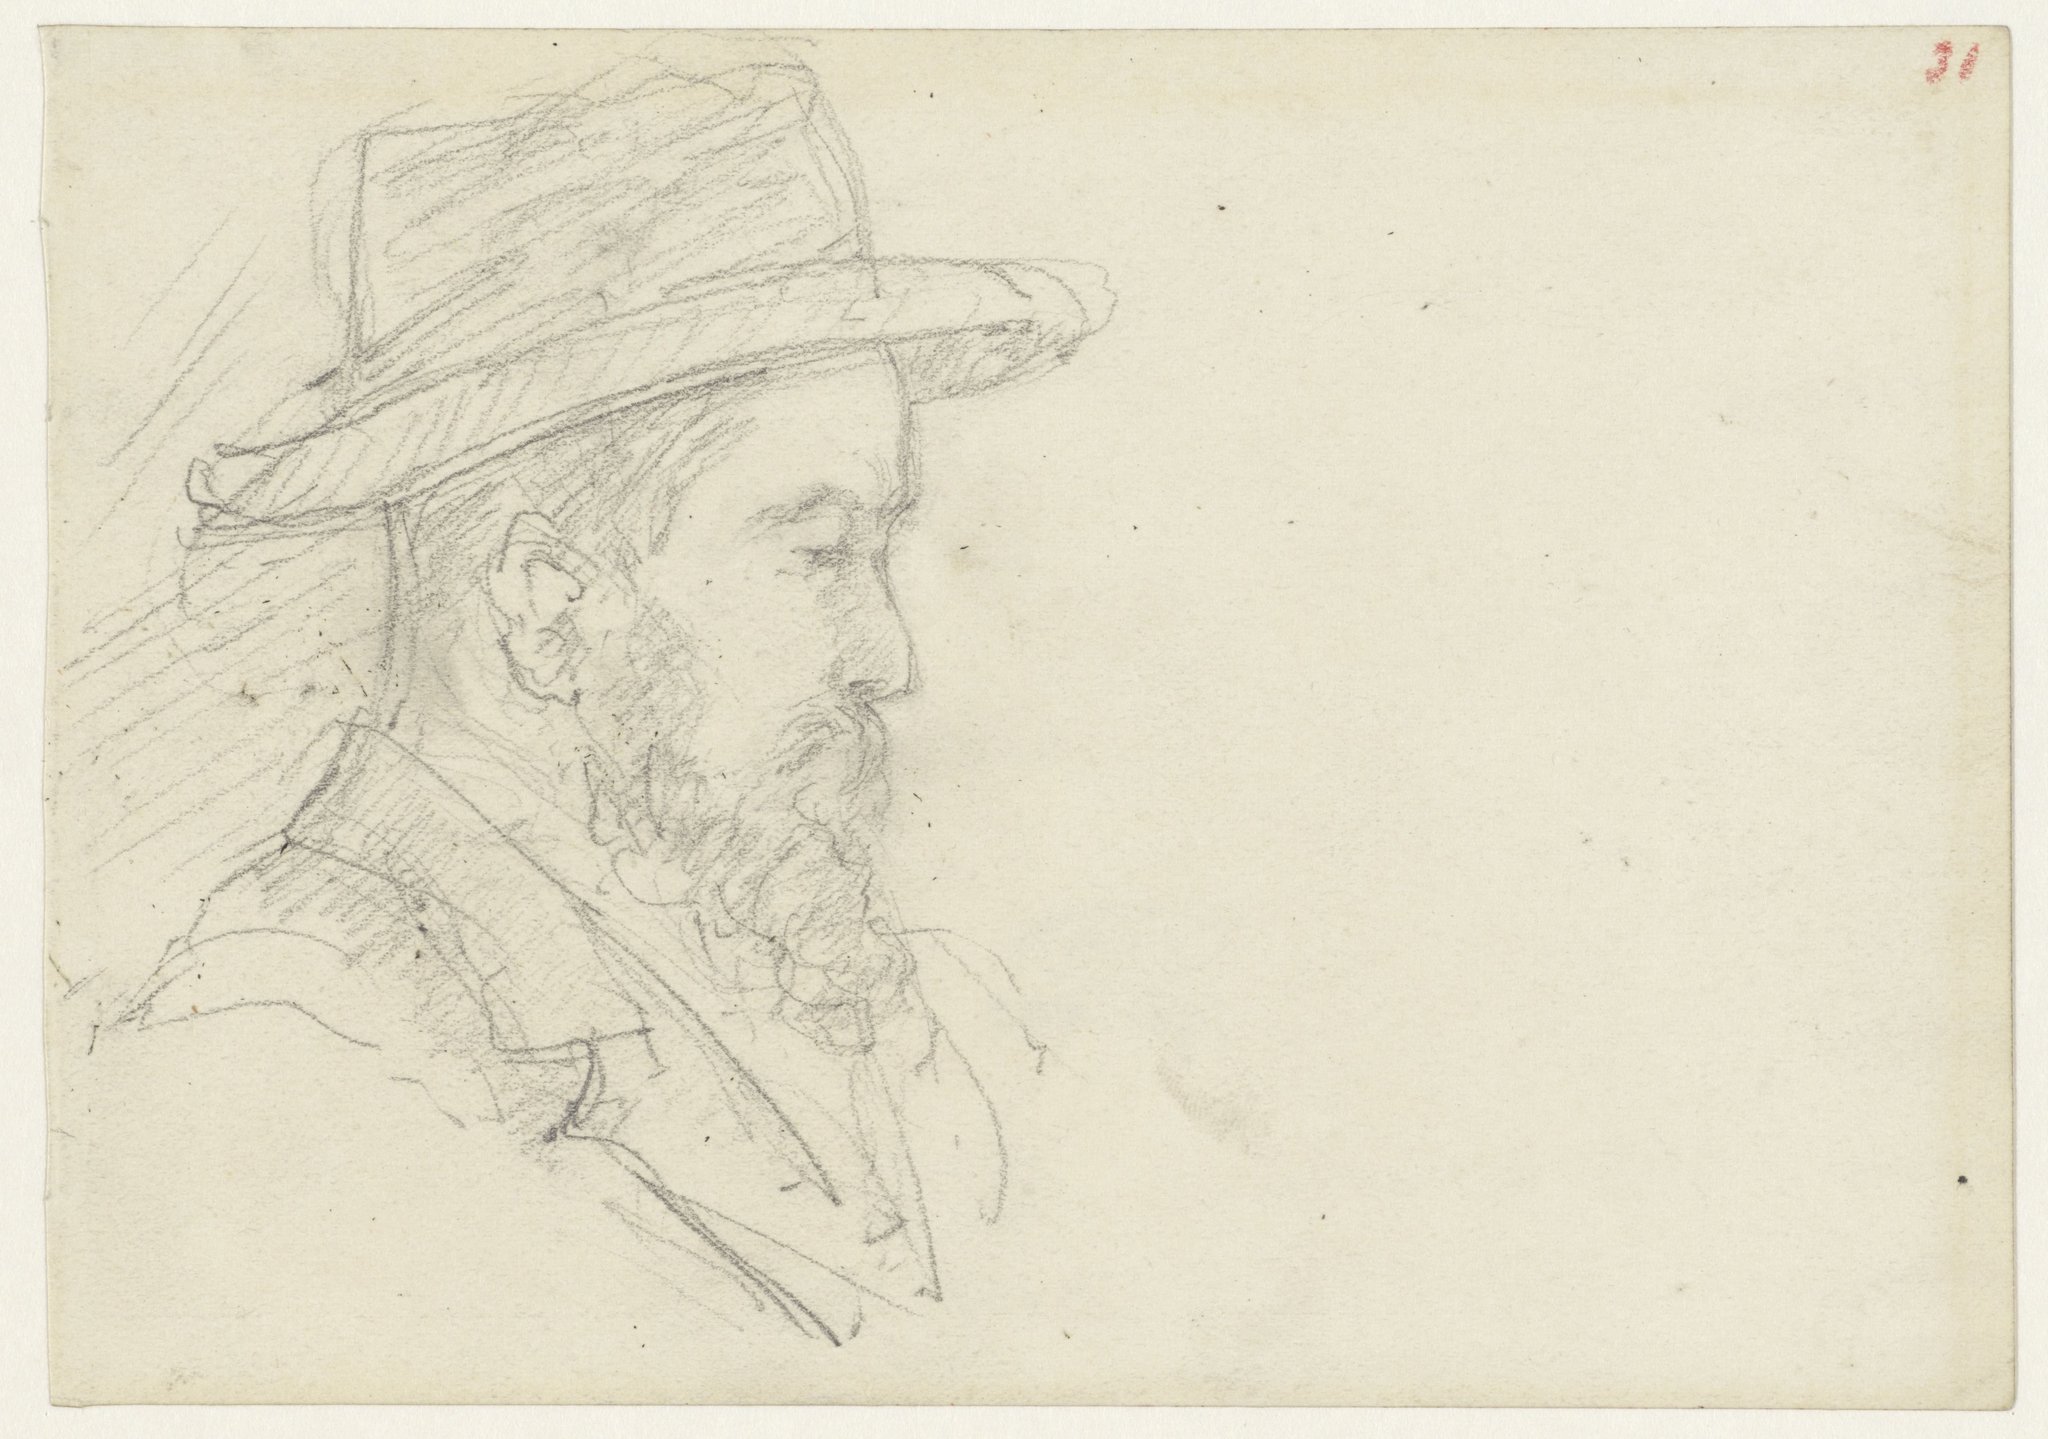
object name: drawing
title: Hoofd van een man met hoed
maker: jozef israëls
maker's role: draughtsman, painter, print maker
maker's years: 1824-1911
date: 1834-1911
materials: paper, pencil